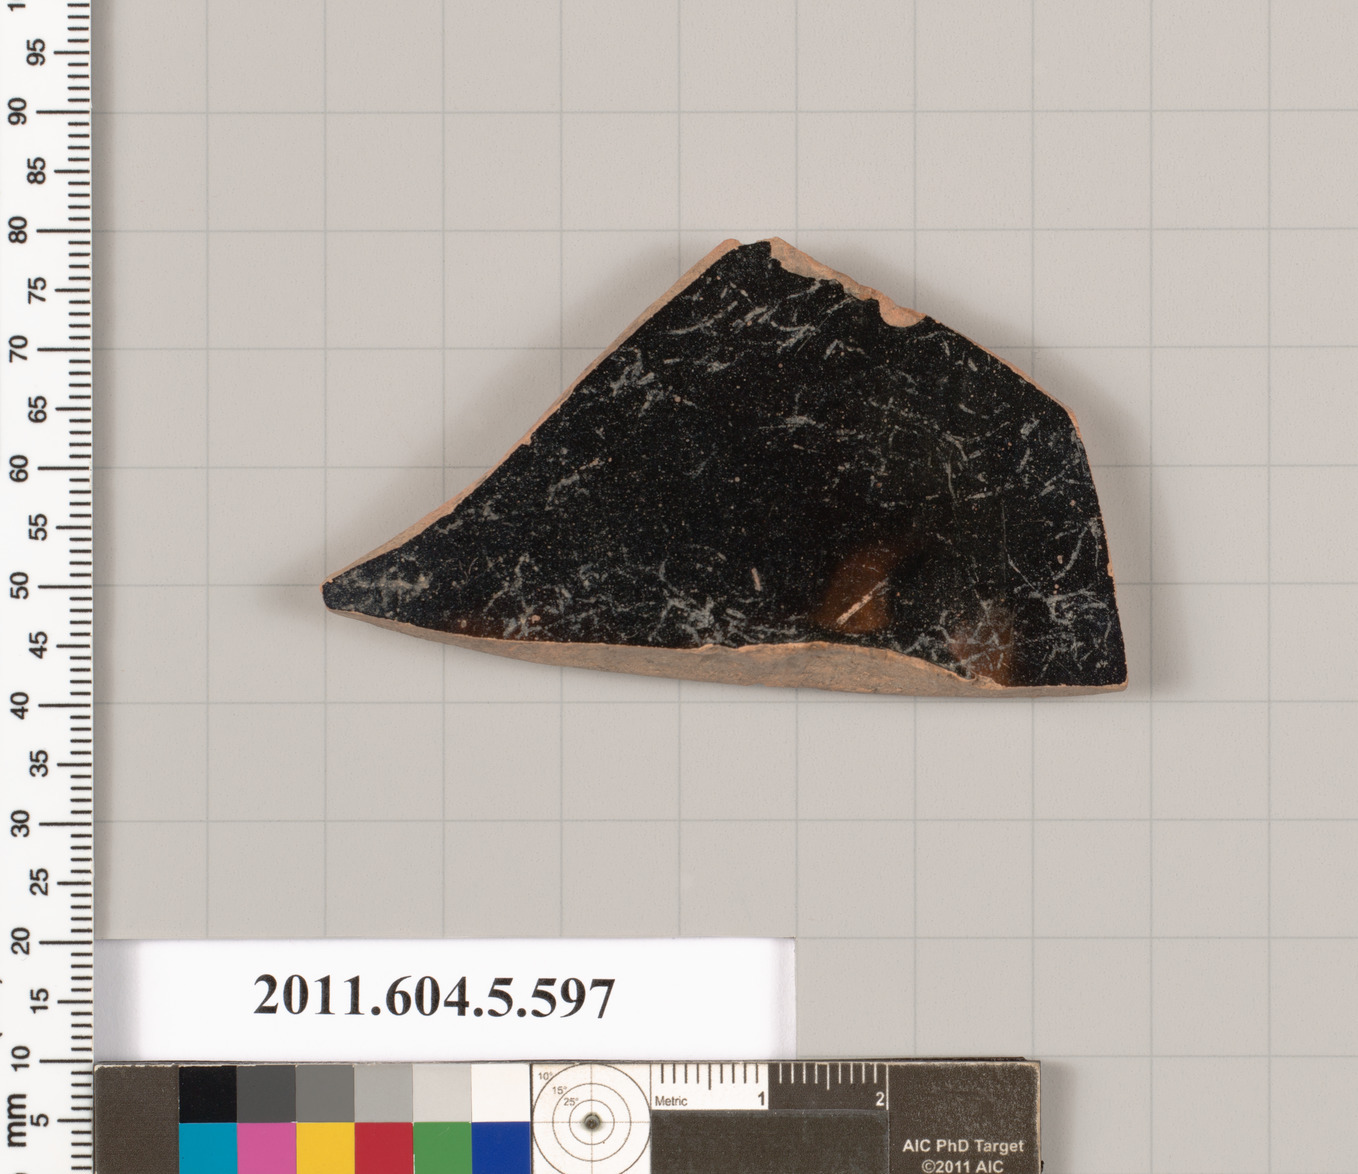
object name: kylix fragment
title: Terracotta fragment of a kylix (drinking cup)?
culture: greek, attic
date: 375-351 BCE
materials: terracotta